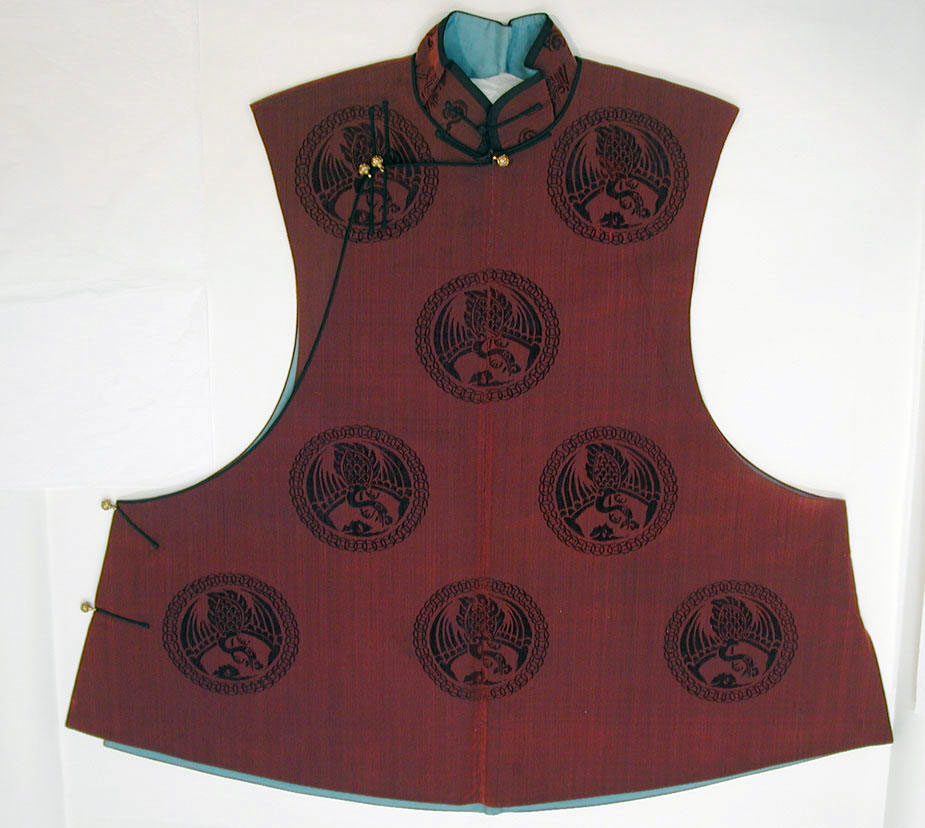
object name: jacket, sleeveless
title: Sleeveless Jacket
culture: chinese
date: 1801-1900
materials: metal, silk, velvet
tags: cranes